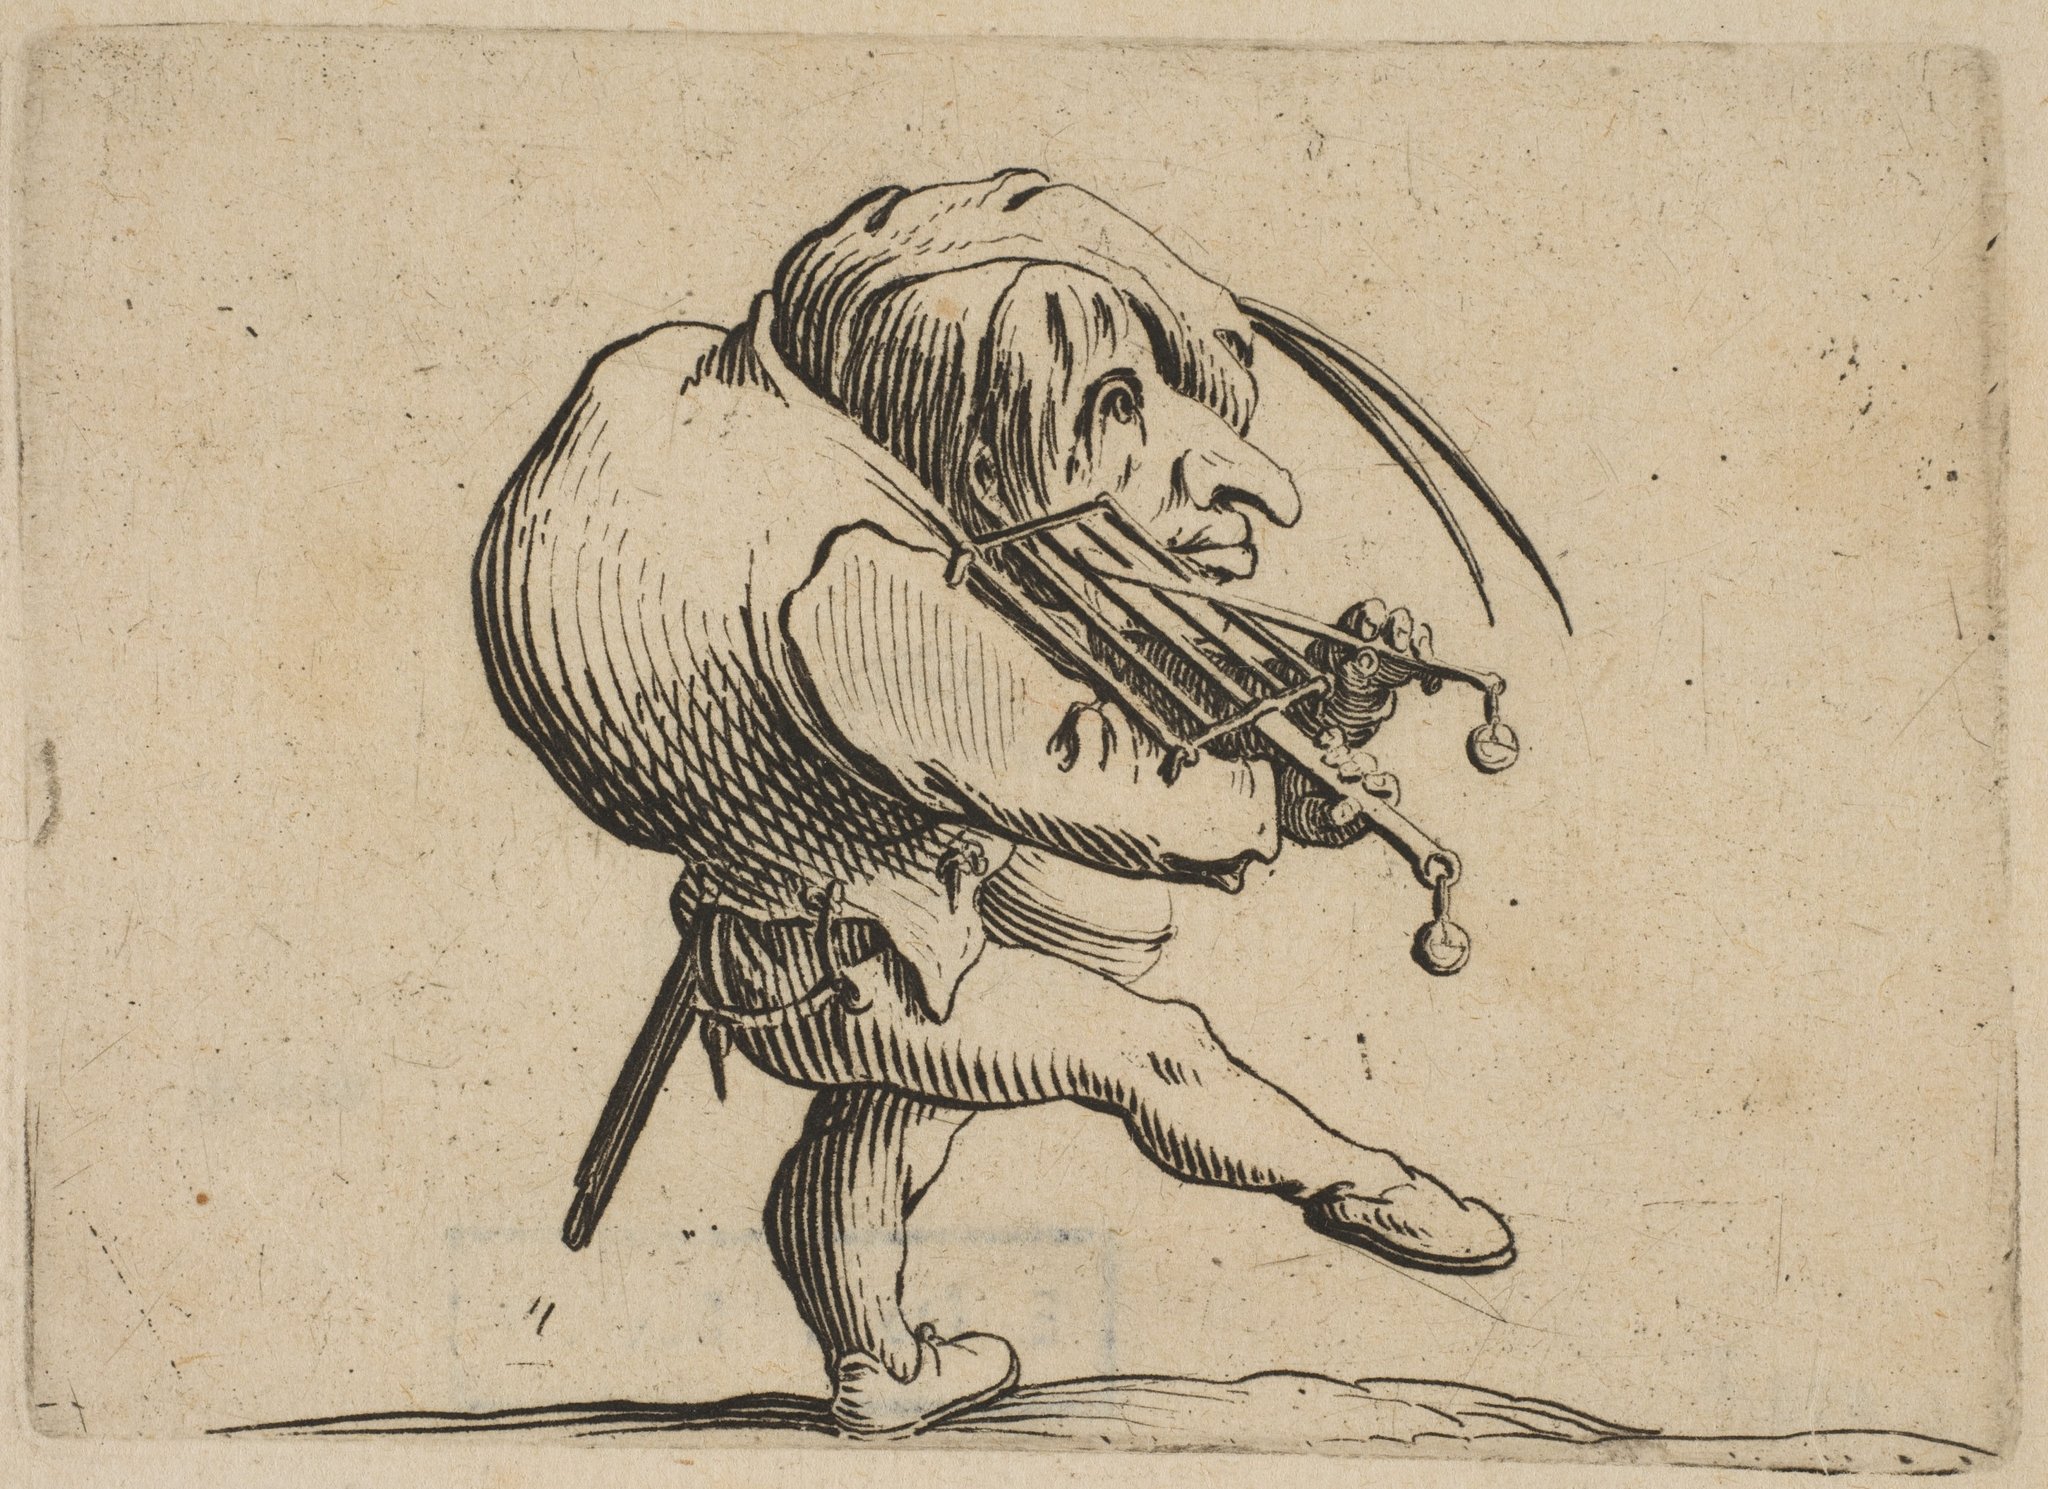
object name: print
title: L'Homme Raclant un Gril en Guise de Violon (Man Scraping a Grill in the Guise of a Violin), from "Varie Figure Gobbi, suite appelée aussi Les Bossus, Les Pygmées, Les Nains Grotesques" (Various Hunchbacked Figures, The Hunchbacks, The Pygmes, The Grotesque Dwarfs)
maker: jacques callot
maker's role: artist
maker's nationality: french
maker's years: 1592-1635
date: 1616-1622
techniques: engraving, etching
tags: violins